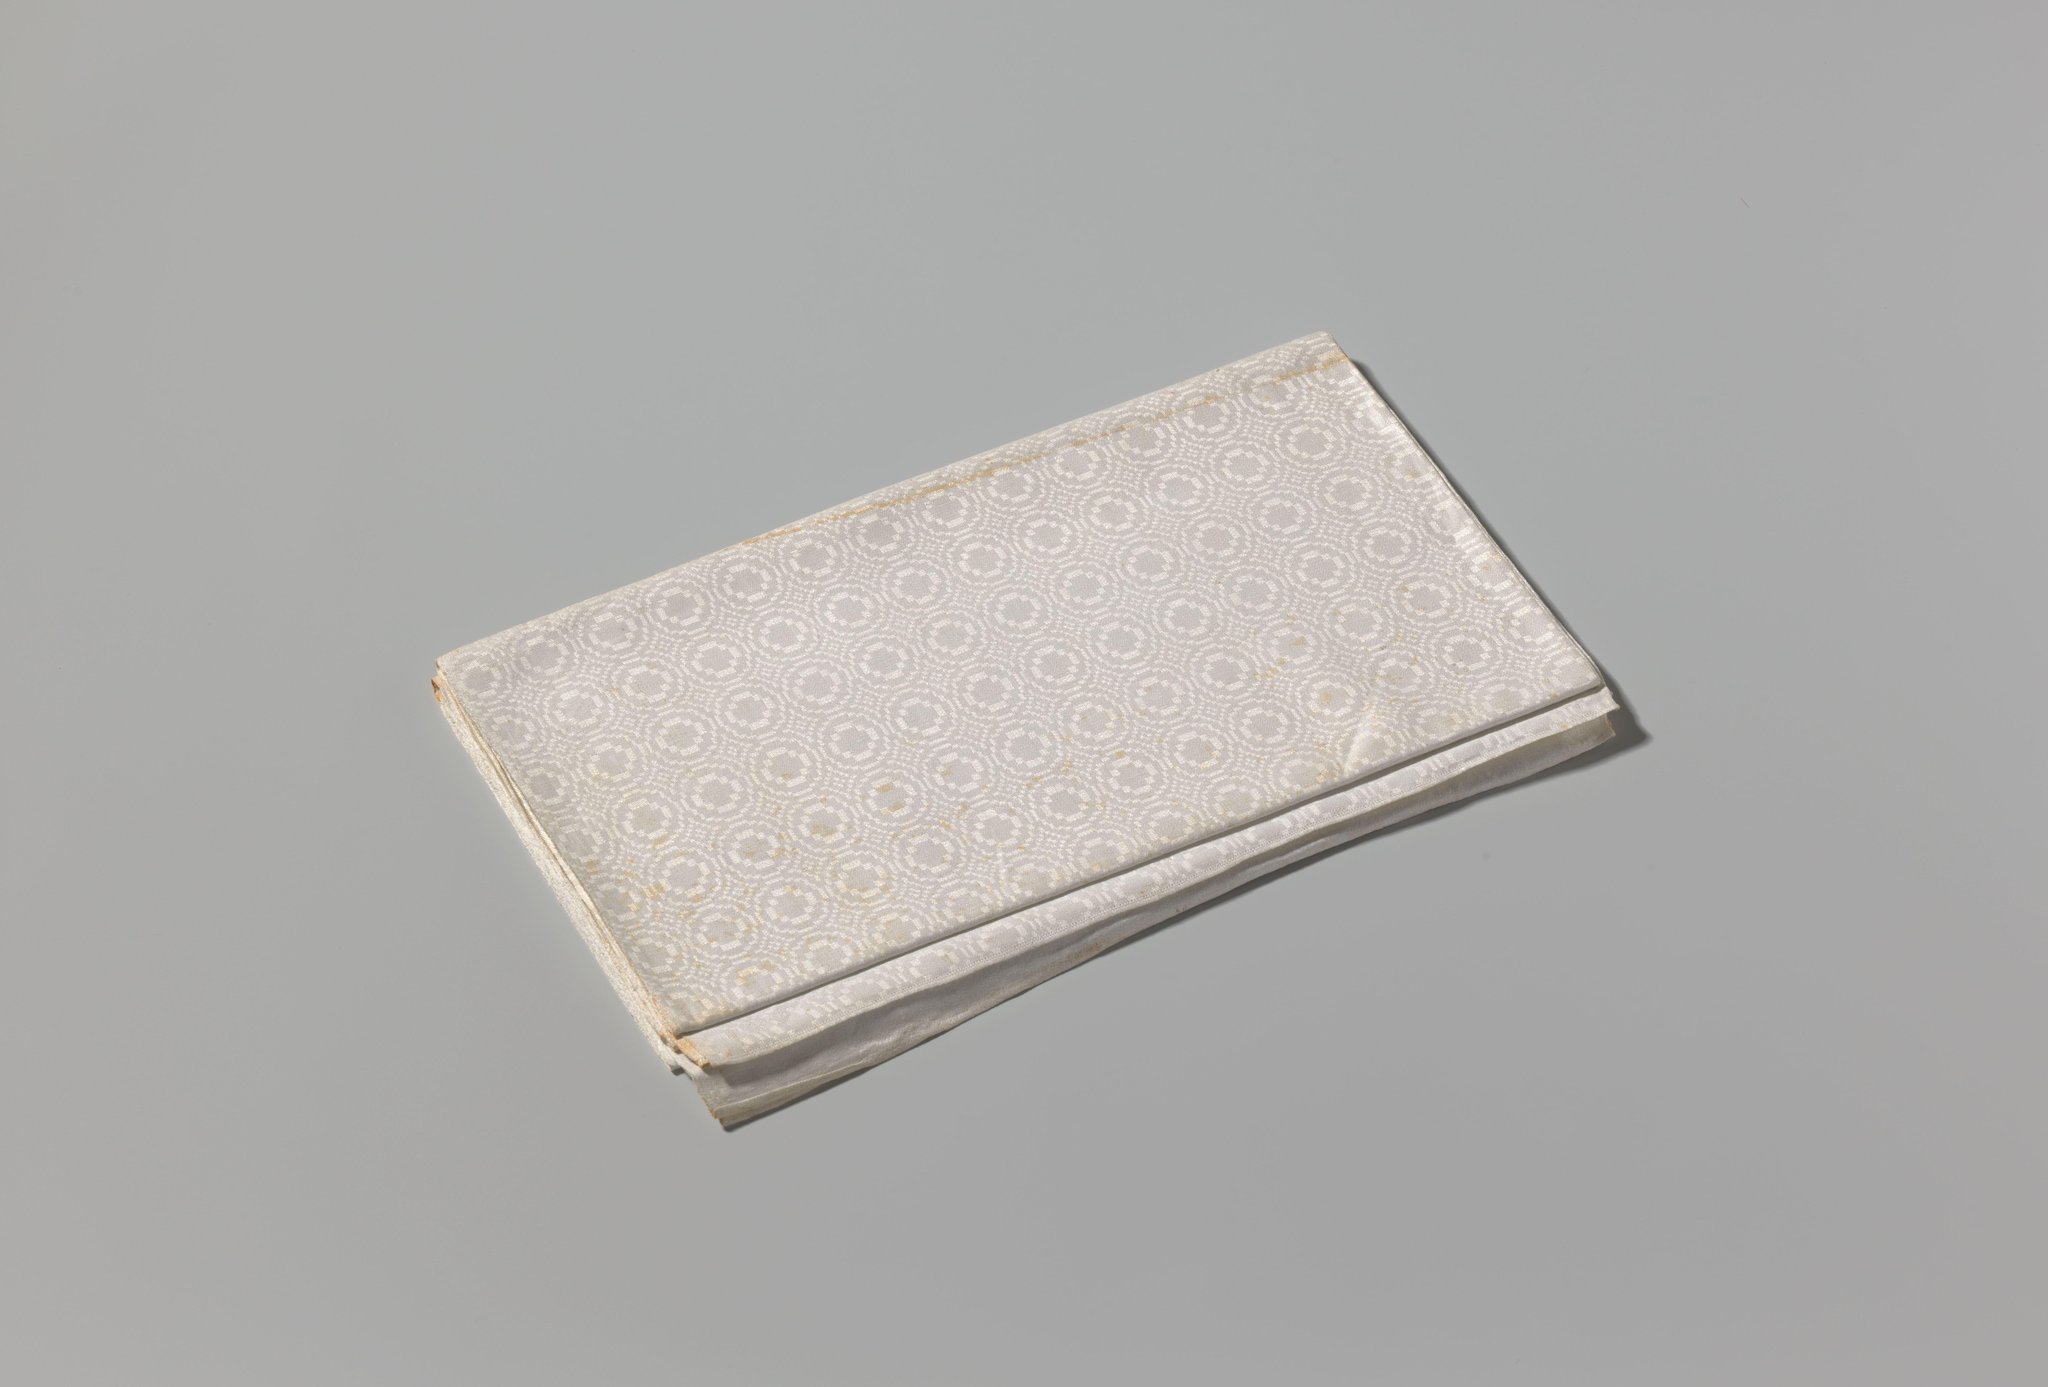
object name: tablecloth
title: Tafellaken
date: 1600-1650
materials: linen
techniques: peeled fabric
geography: northern netherlands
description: Wit linnen tafellaken met pellen patroon. Merk kroon IVG.